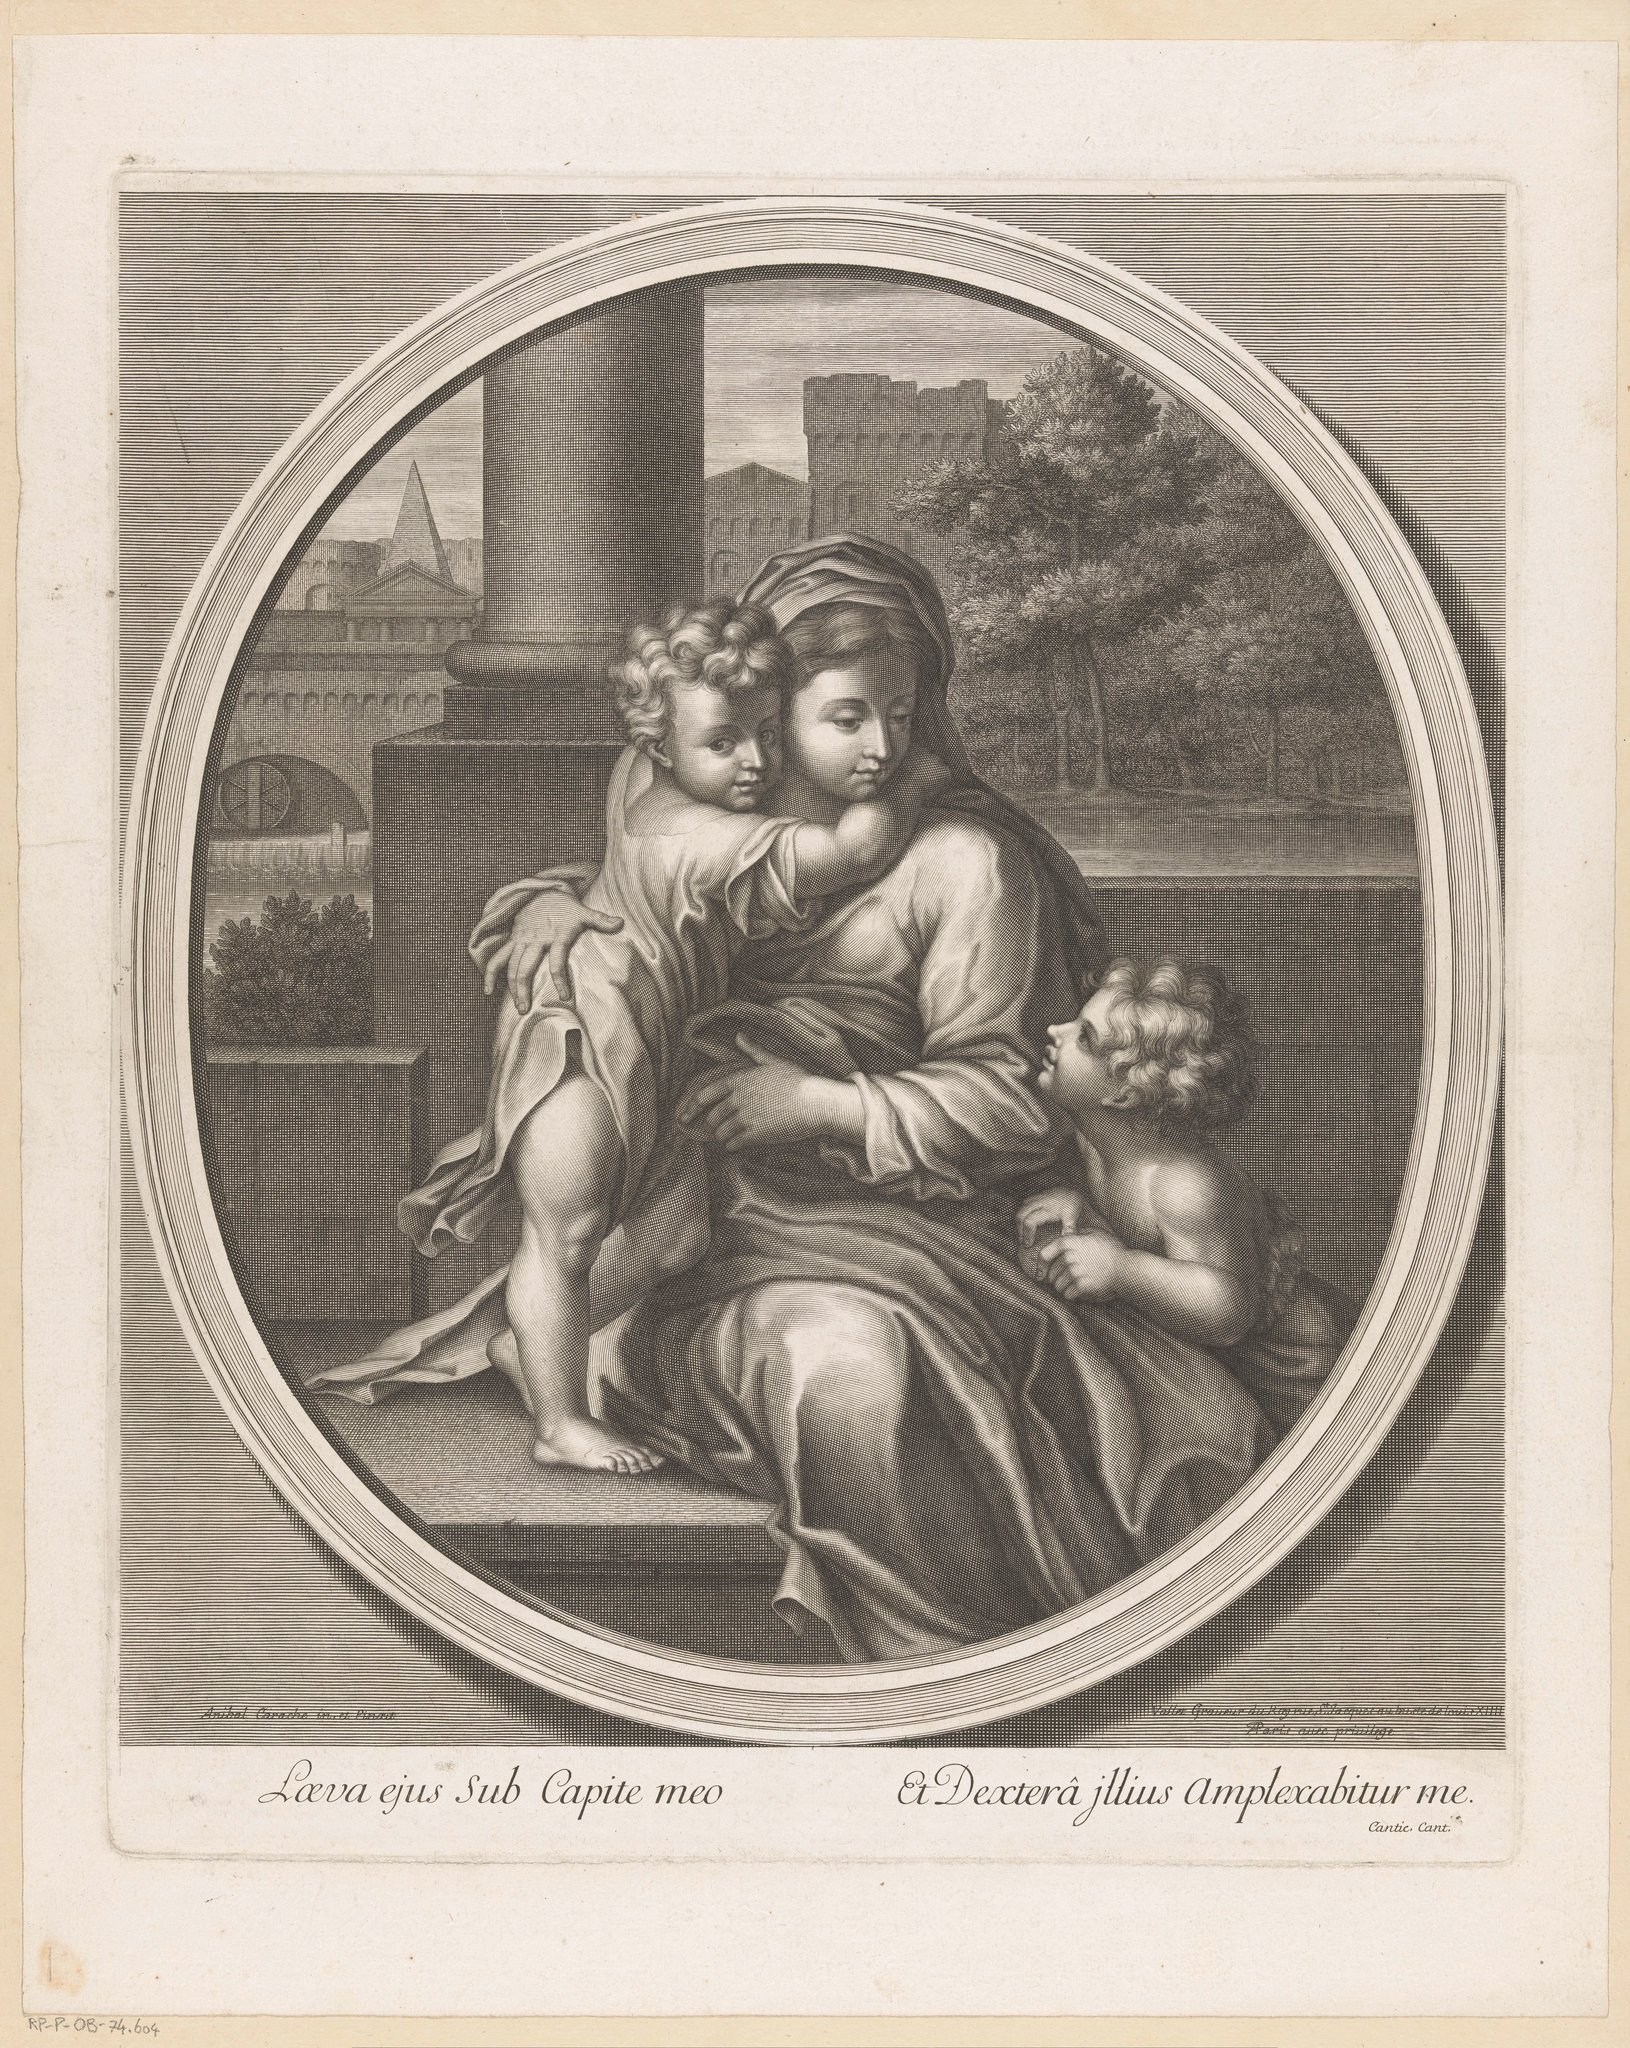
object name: print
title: Maria met het Christuskind en Johannes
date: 1661-1704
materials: paper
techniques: engraving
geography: france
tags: mary and the christ-child with john the baptist (as child)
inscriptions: collector's mark: Lugt 240